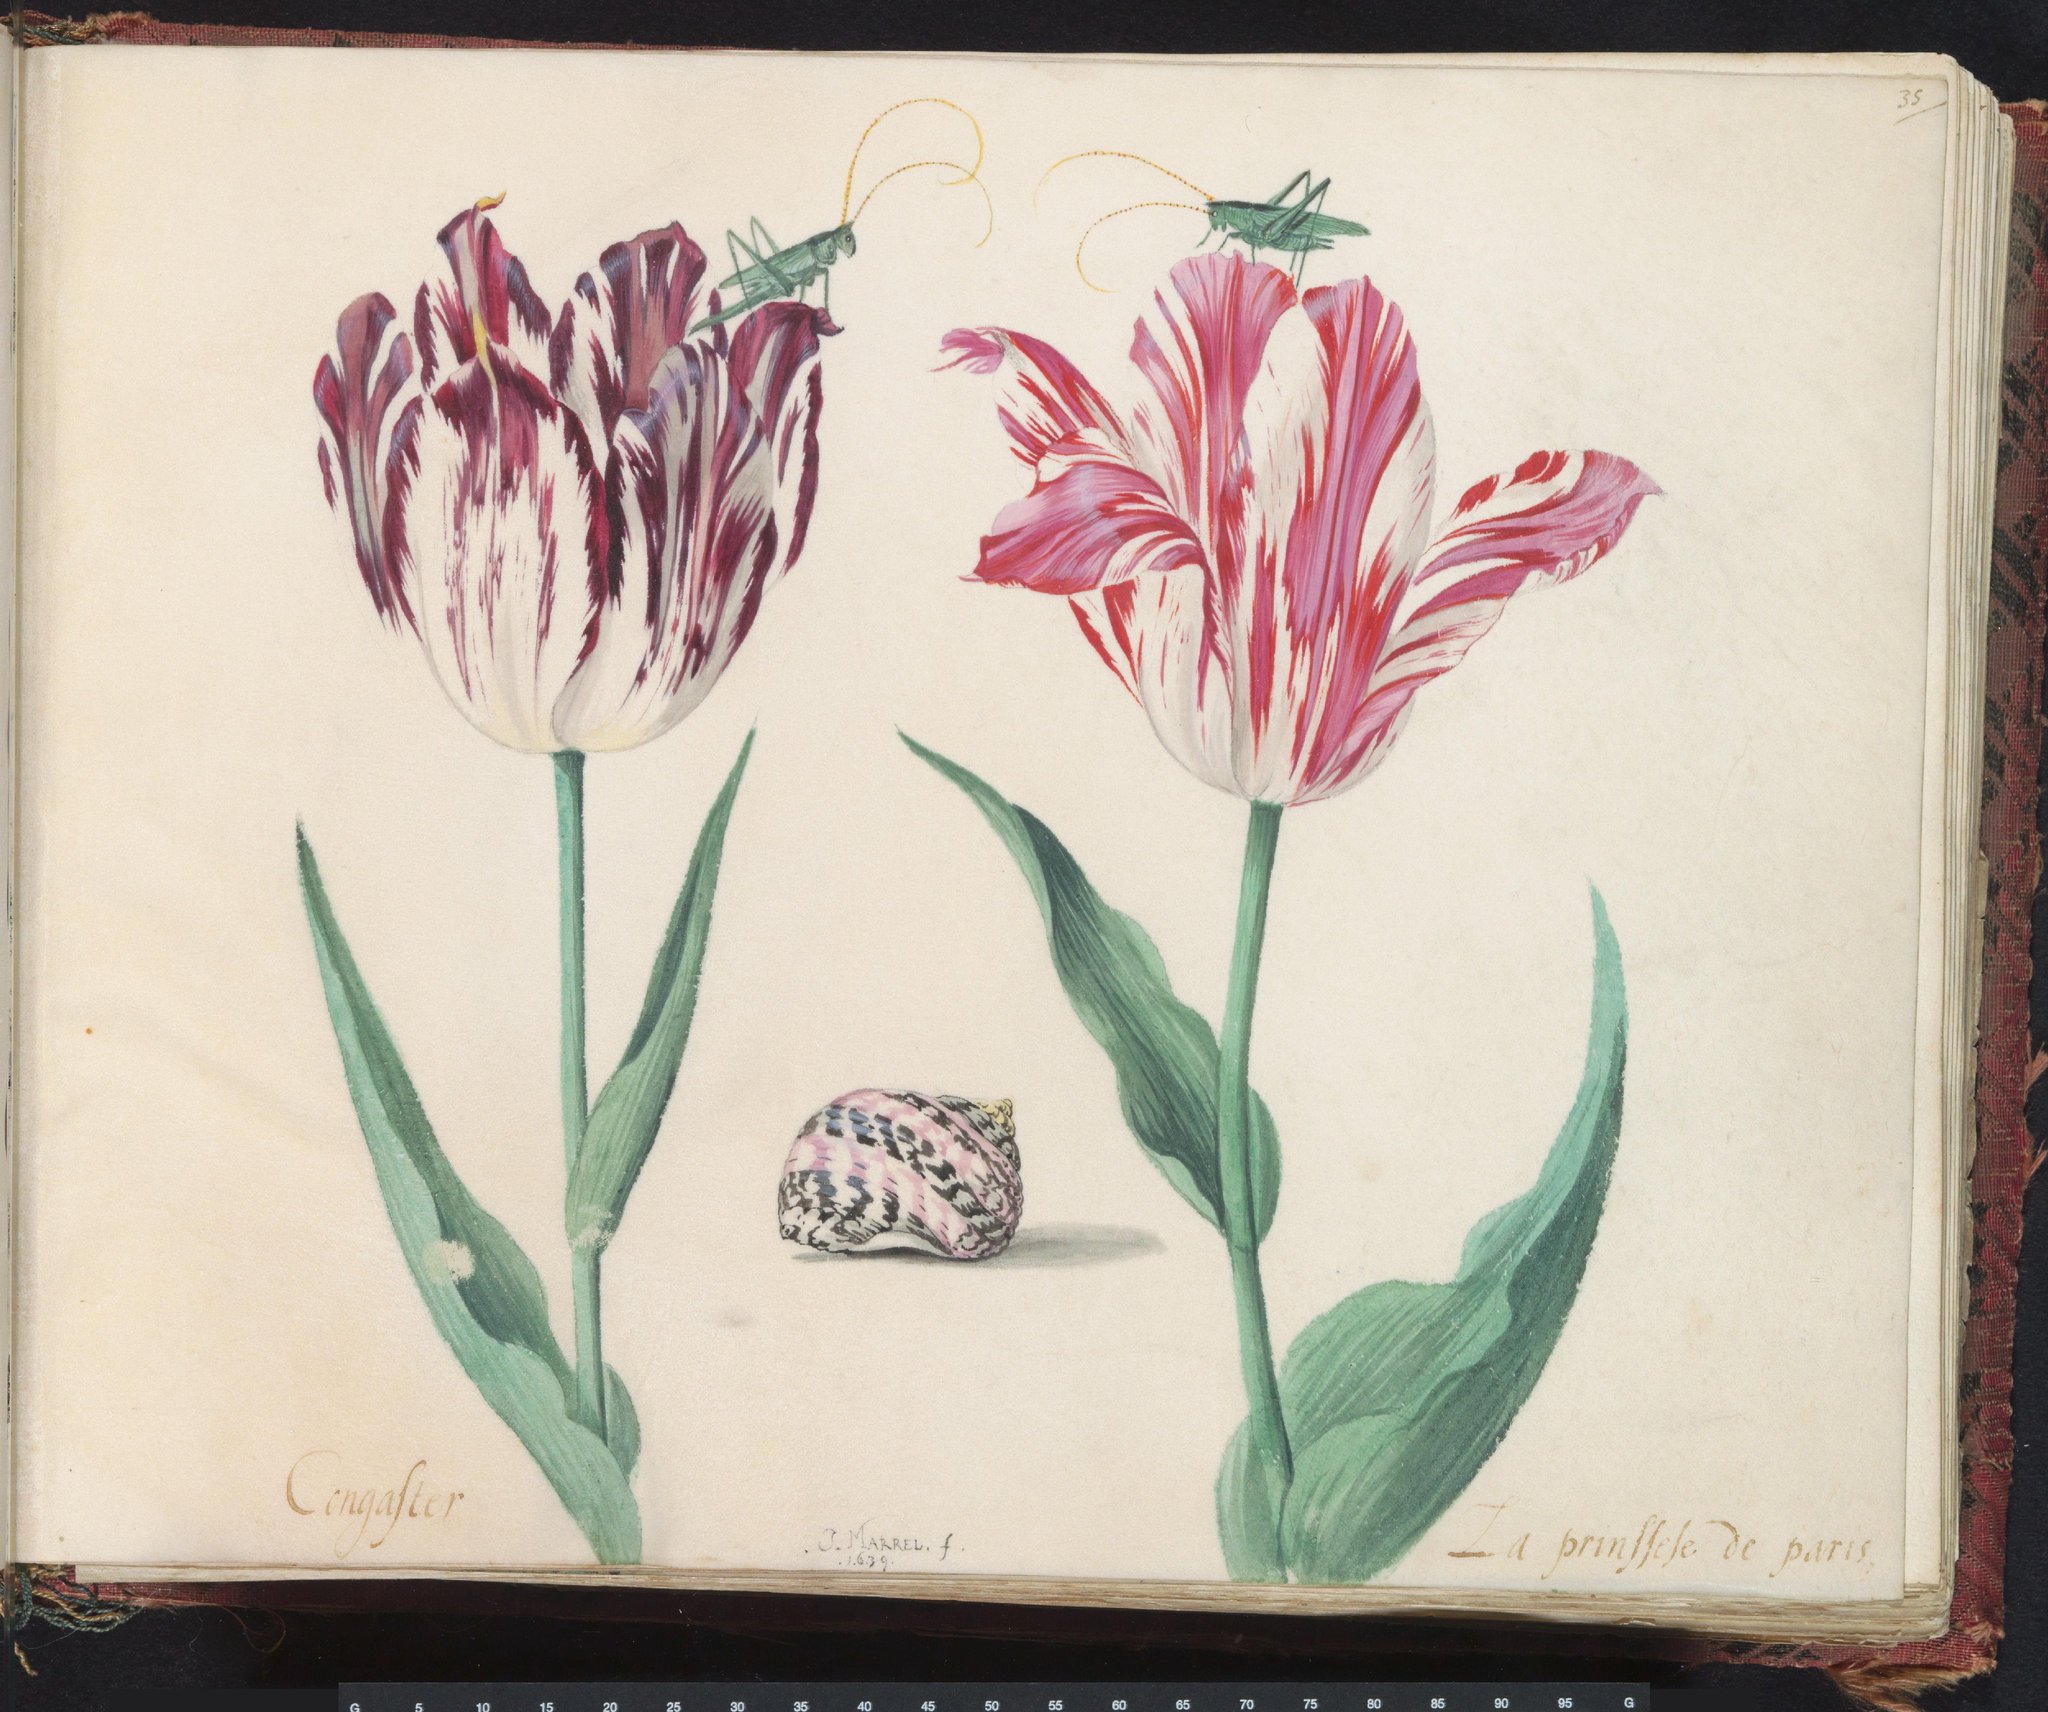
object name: drawing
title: Congaster / La prinssese de paris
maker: jacob marrel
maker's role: draughtsman, painter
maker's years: 1614-1681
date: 1639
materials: paint, parchment, pencil, watercolor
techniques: brush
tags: flowers: tulip, molluscs (+ shell, snail-shell etc.), insects: cricket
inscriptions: date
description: De tekening maakt deel uit van een album.